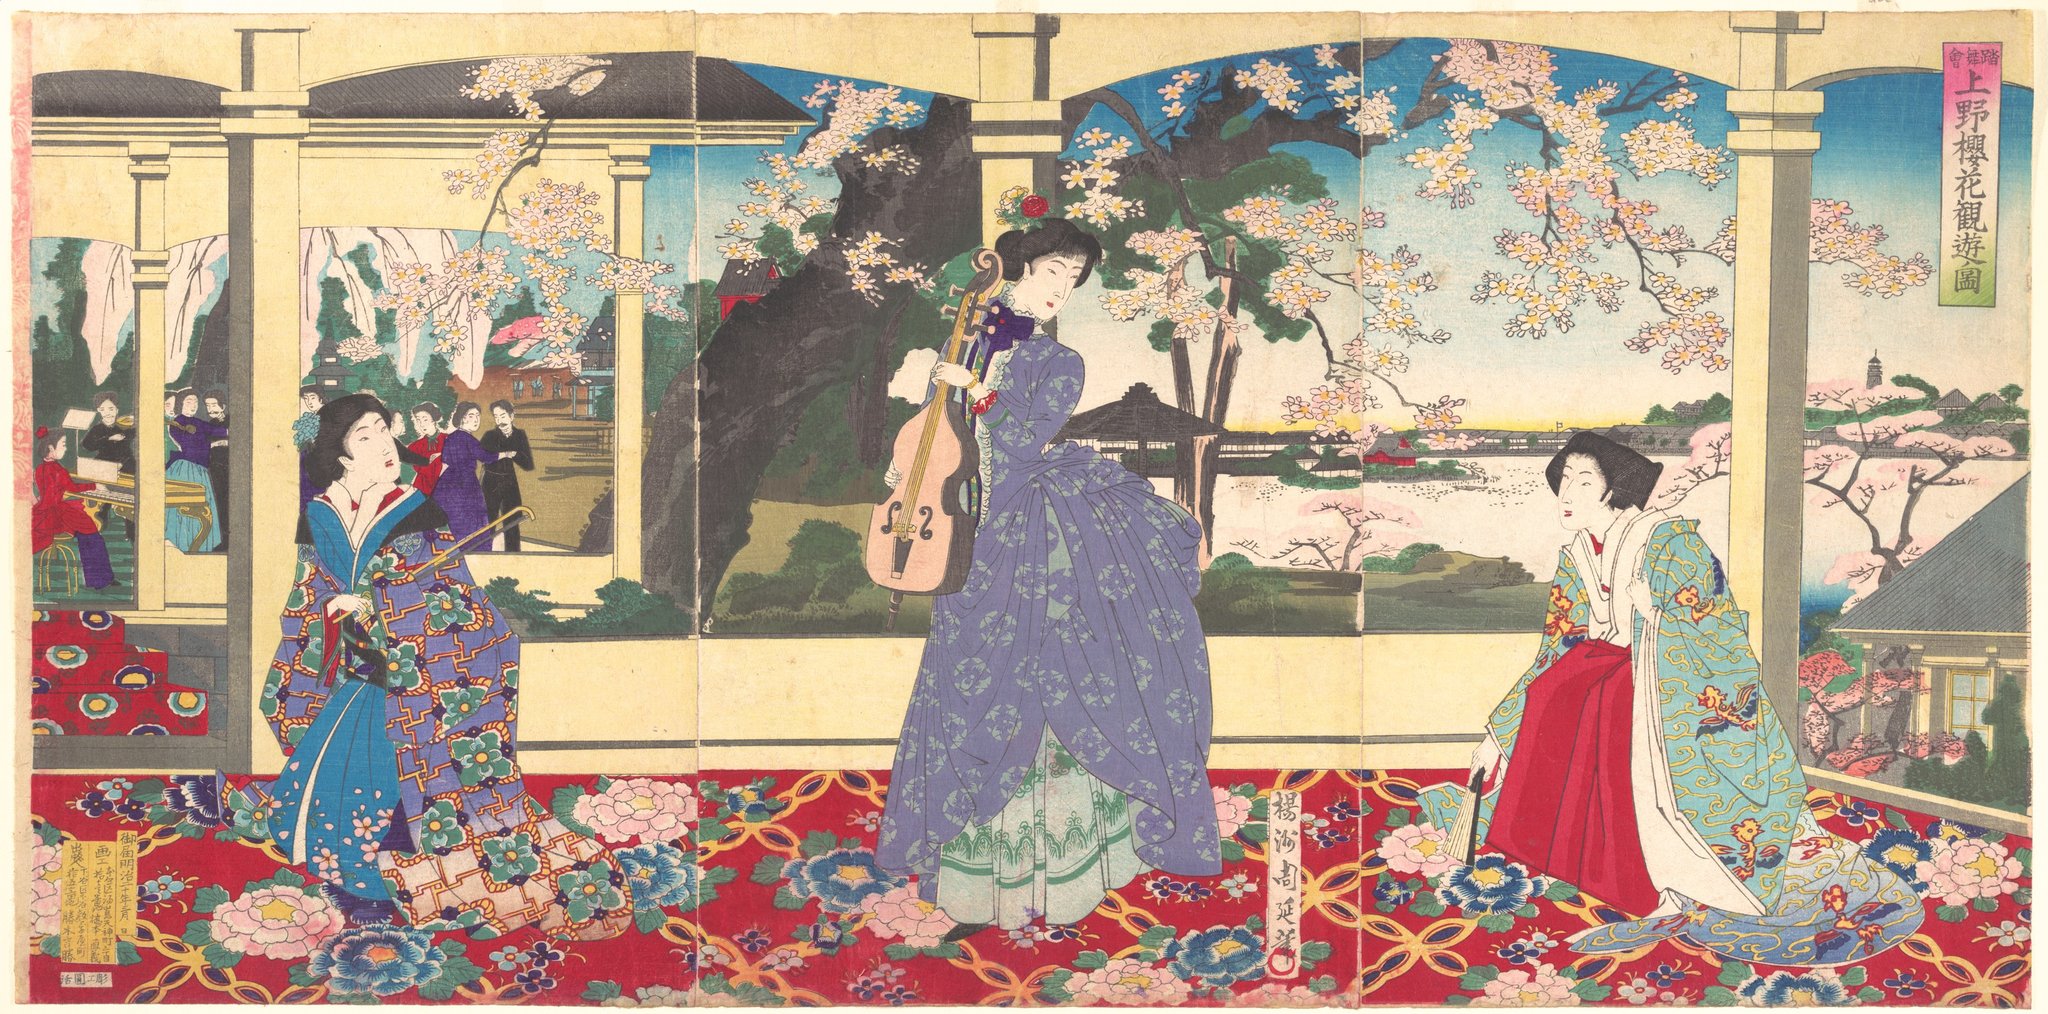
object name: print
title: A Dance Party: Enjoying Cherry Blossom Viewing at Ueno (Tōbukai Ueno ōka yūran no zu)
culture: japanese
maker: yōshū (hashimoto) chikanobu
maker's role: artist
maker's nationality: japanese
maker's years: 1838-1912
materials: ink, paper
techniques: woodblock print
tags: women,party,violins,flowers,trees